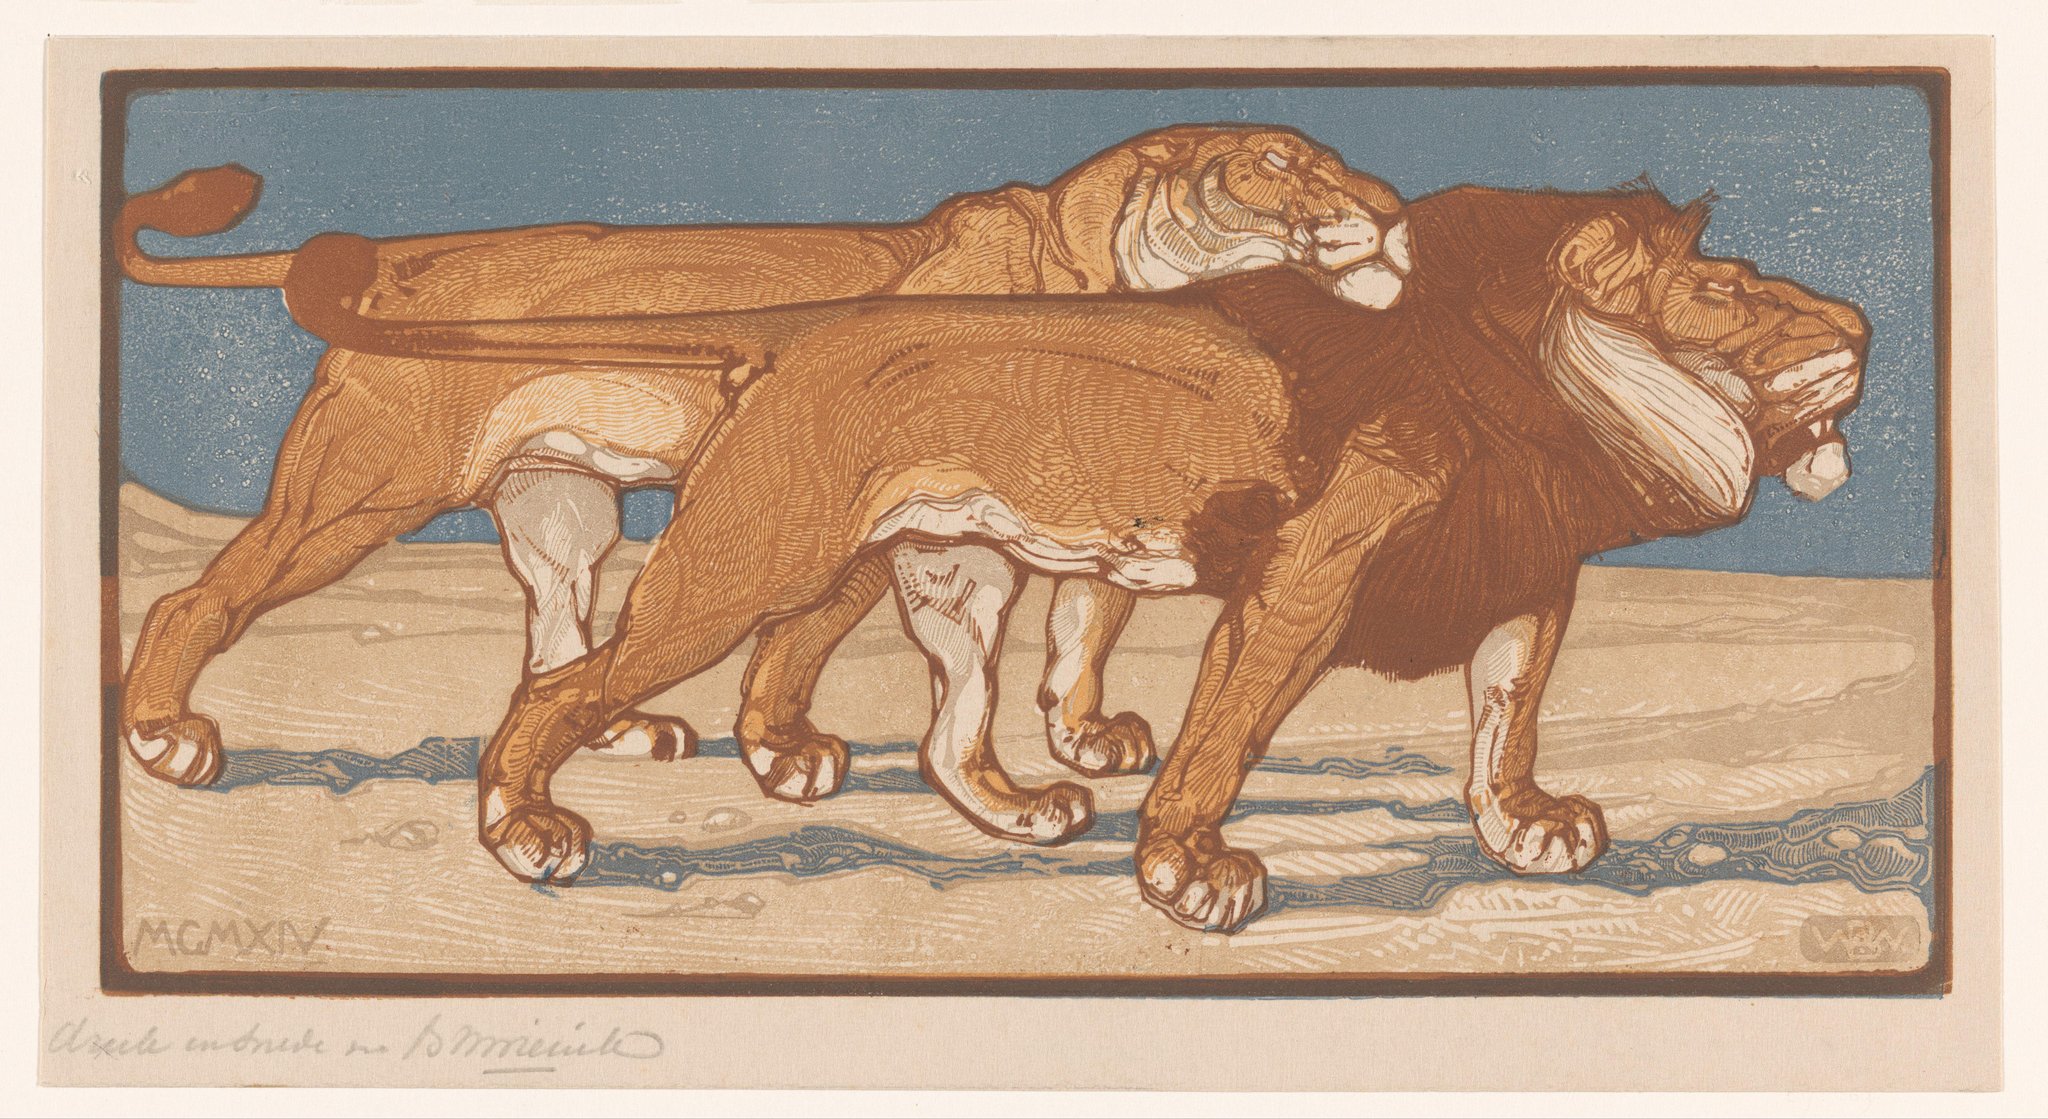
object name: print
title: Leeuw en leeuwin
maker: bernard willem wierink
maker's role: draughtsman, print maker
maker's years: 1856-1939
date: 1914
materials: paper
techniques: relief print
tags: beasts of prey, predatory animals: lion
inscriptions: collector's mark: Lugt 2228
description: Deze prent is vermoedelijk een plaatsnede, ook al wordt in de literatuur veelal gesproken over een houtsnede. Voor zover Wierink zijn prenten in hoogdruk zelf nader heeft omschreven, heeft hij altijd de term 'plaatsnede' gebruikt.